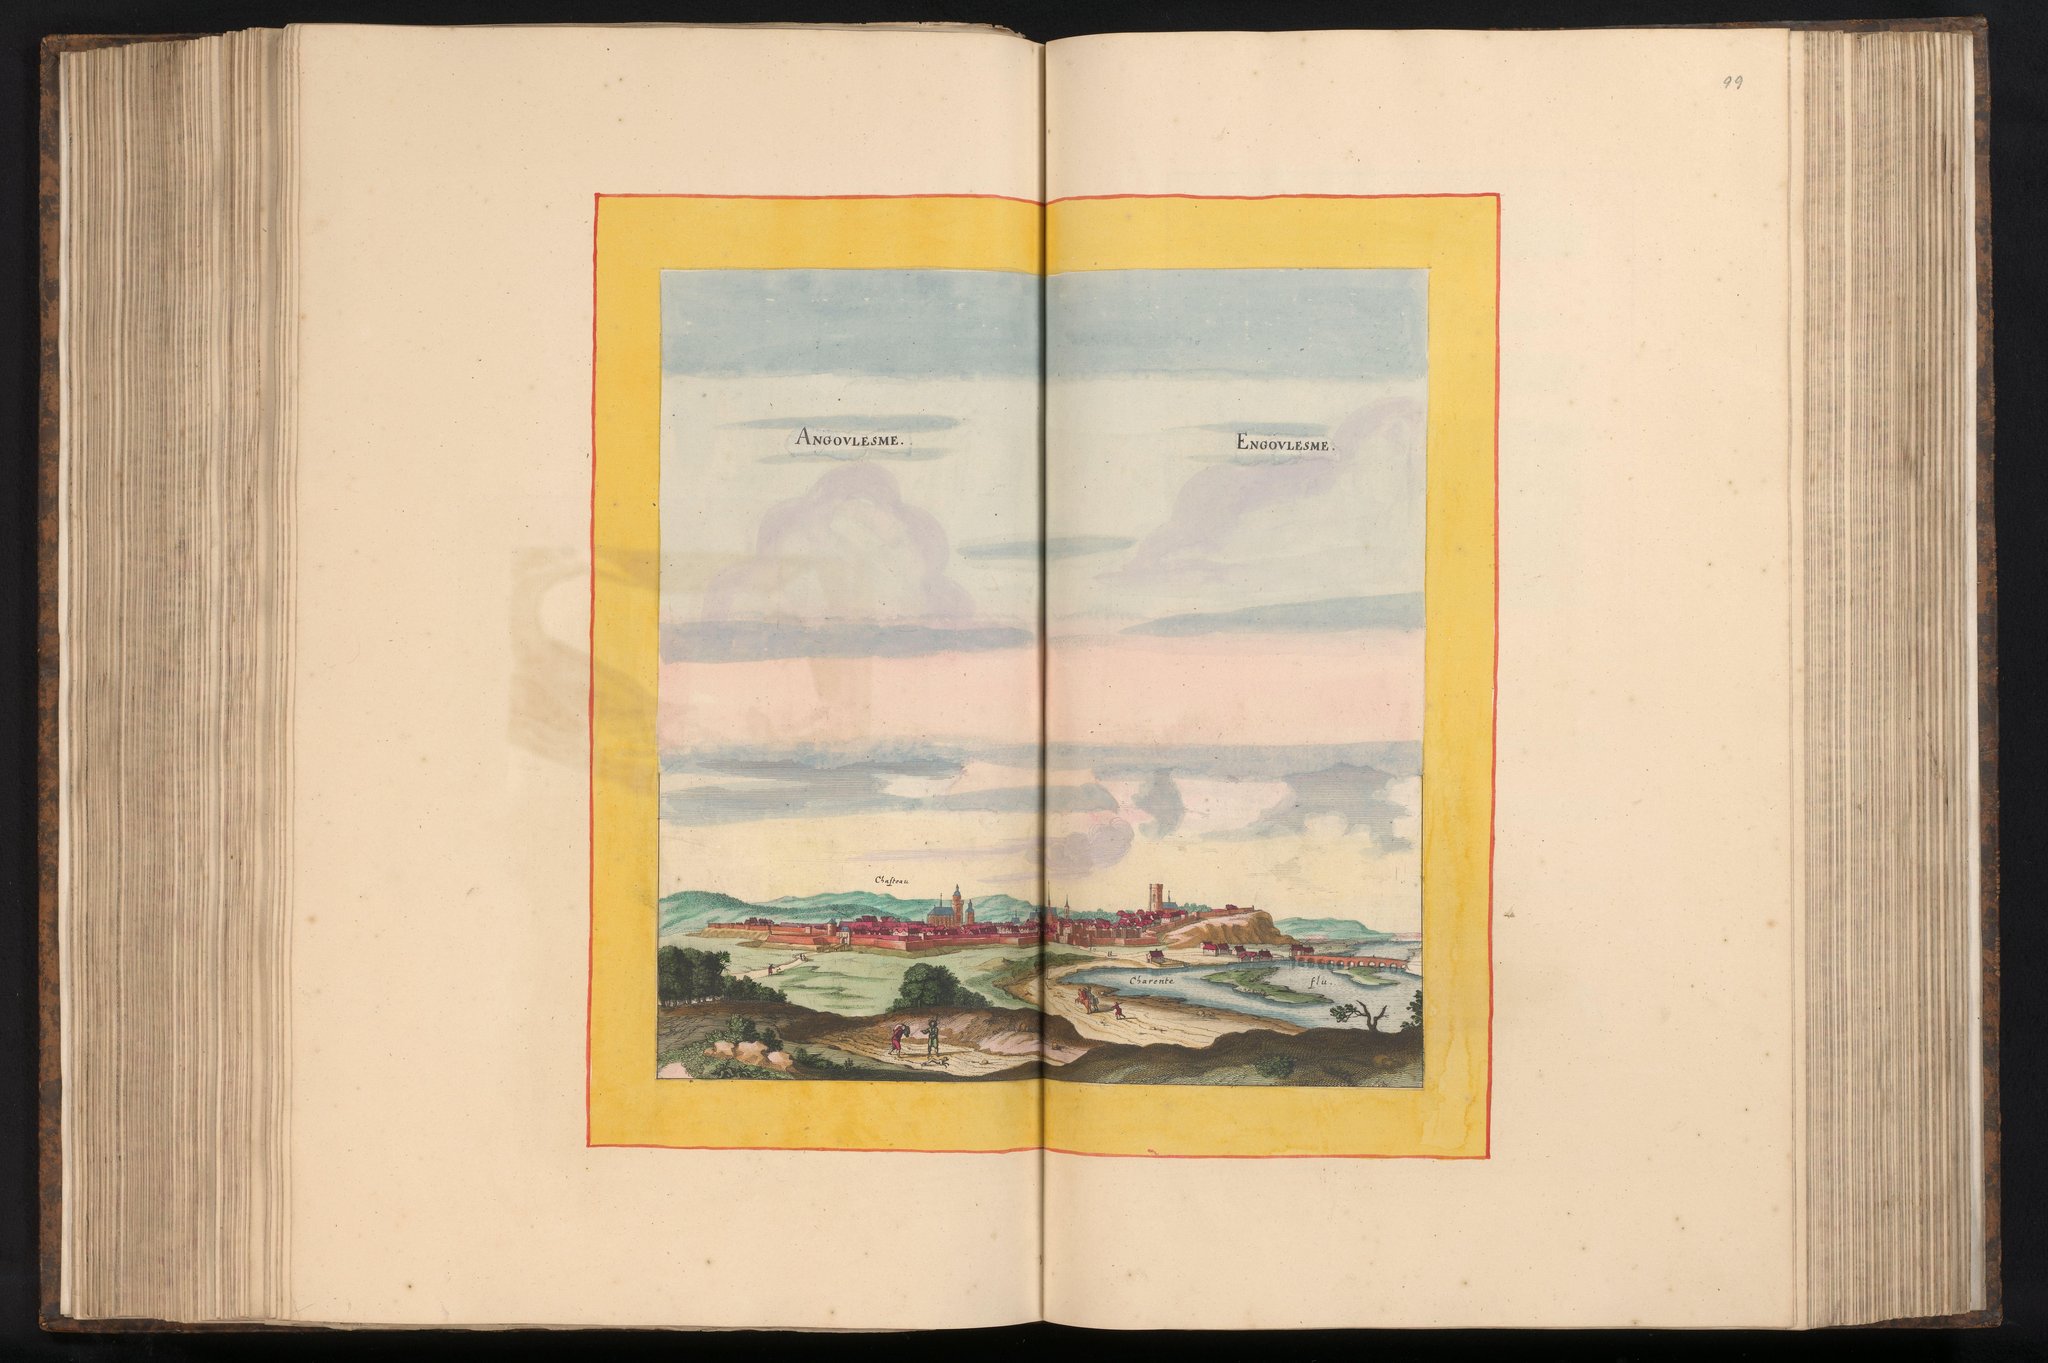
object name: album leaf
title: Gezicht op Angoulême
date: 1657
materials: paper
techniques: engraving, etching, hand coloring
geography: the hague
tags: city-view in general; 'veduta'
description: Prent uit: Zeiller, Martin. Topographia Galliae. 13 dln. Frankfurt: Caspar Merian, 1657, dl. 7, na p. 12. De titel is uit de originele prent gesneden. Boven de gravure is een deel lucht en wolken (bij)geschilderd, waarin de titel gelijmd is. Origineel op één blad gedrukt met het gezicht op Blois (RP-P-1956-186).